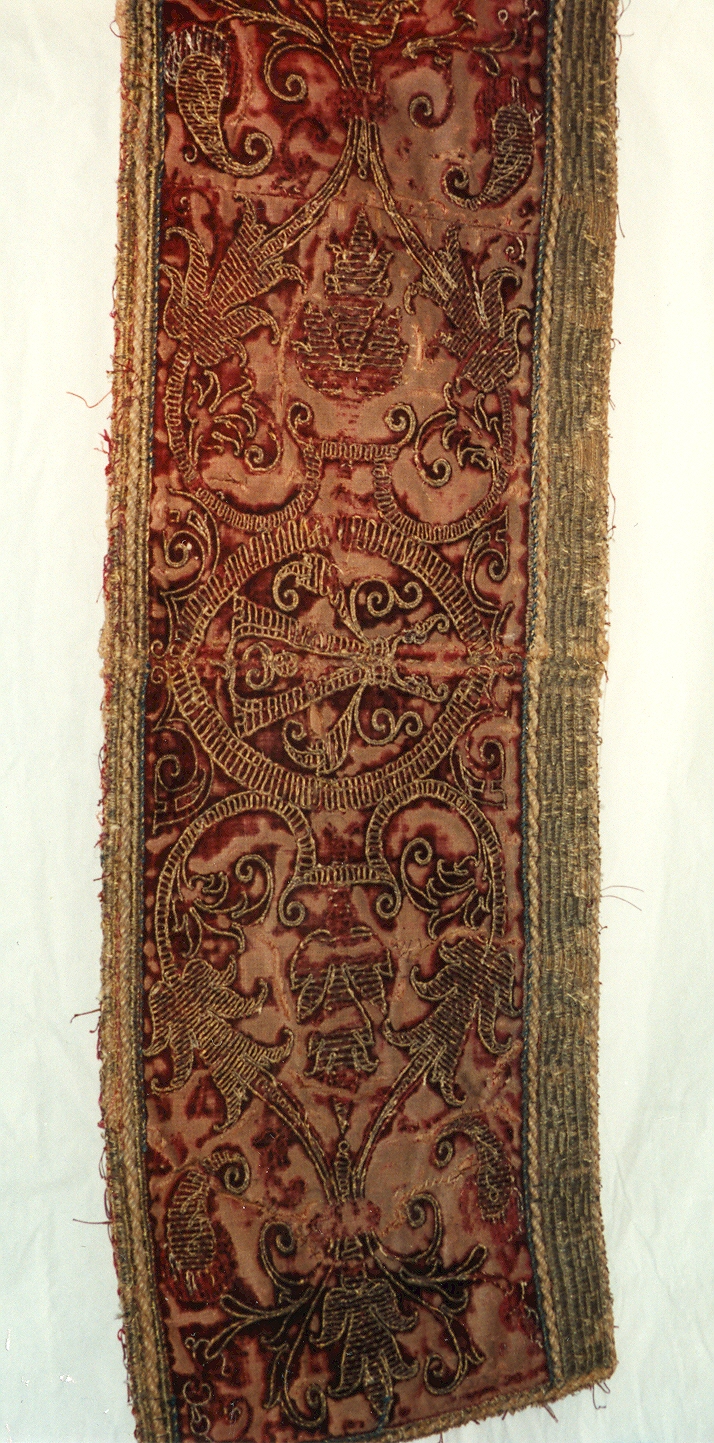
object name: clothing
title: Panel (Apparel?)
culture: italian or spanish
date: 1601-1700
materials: metal, silk